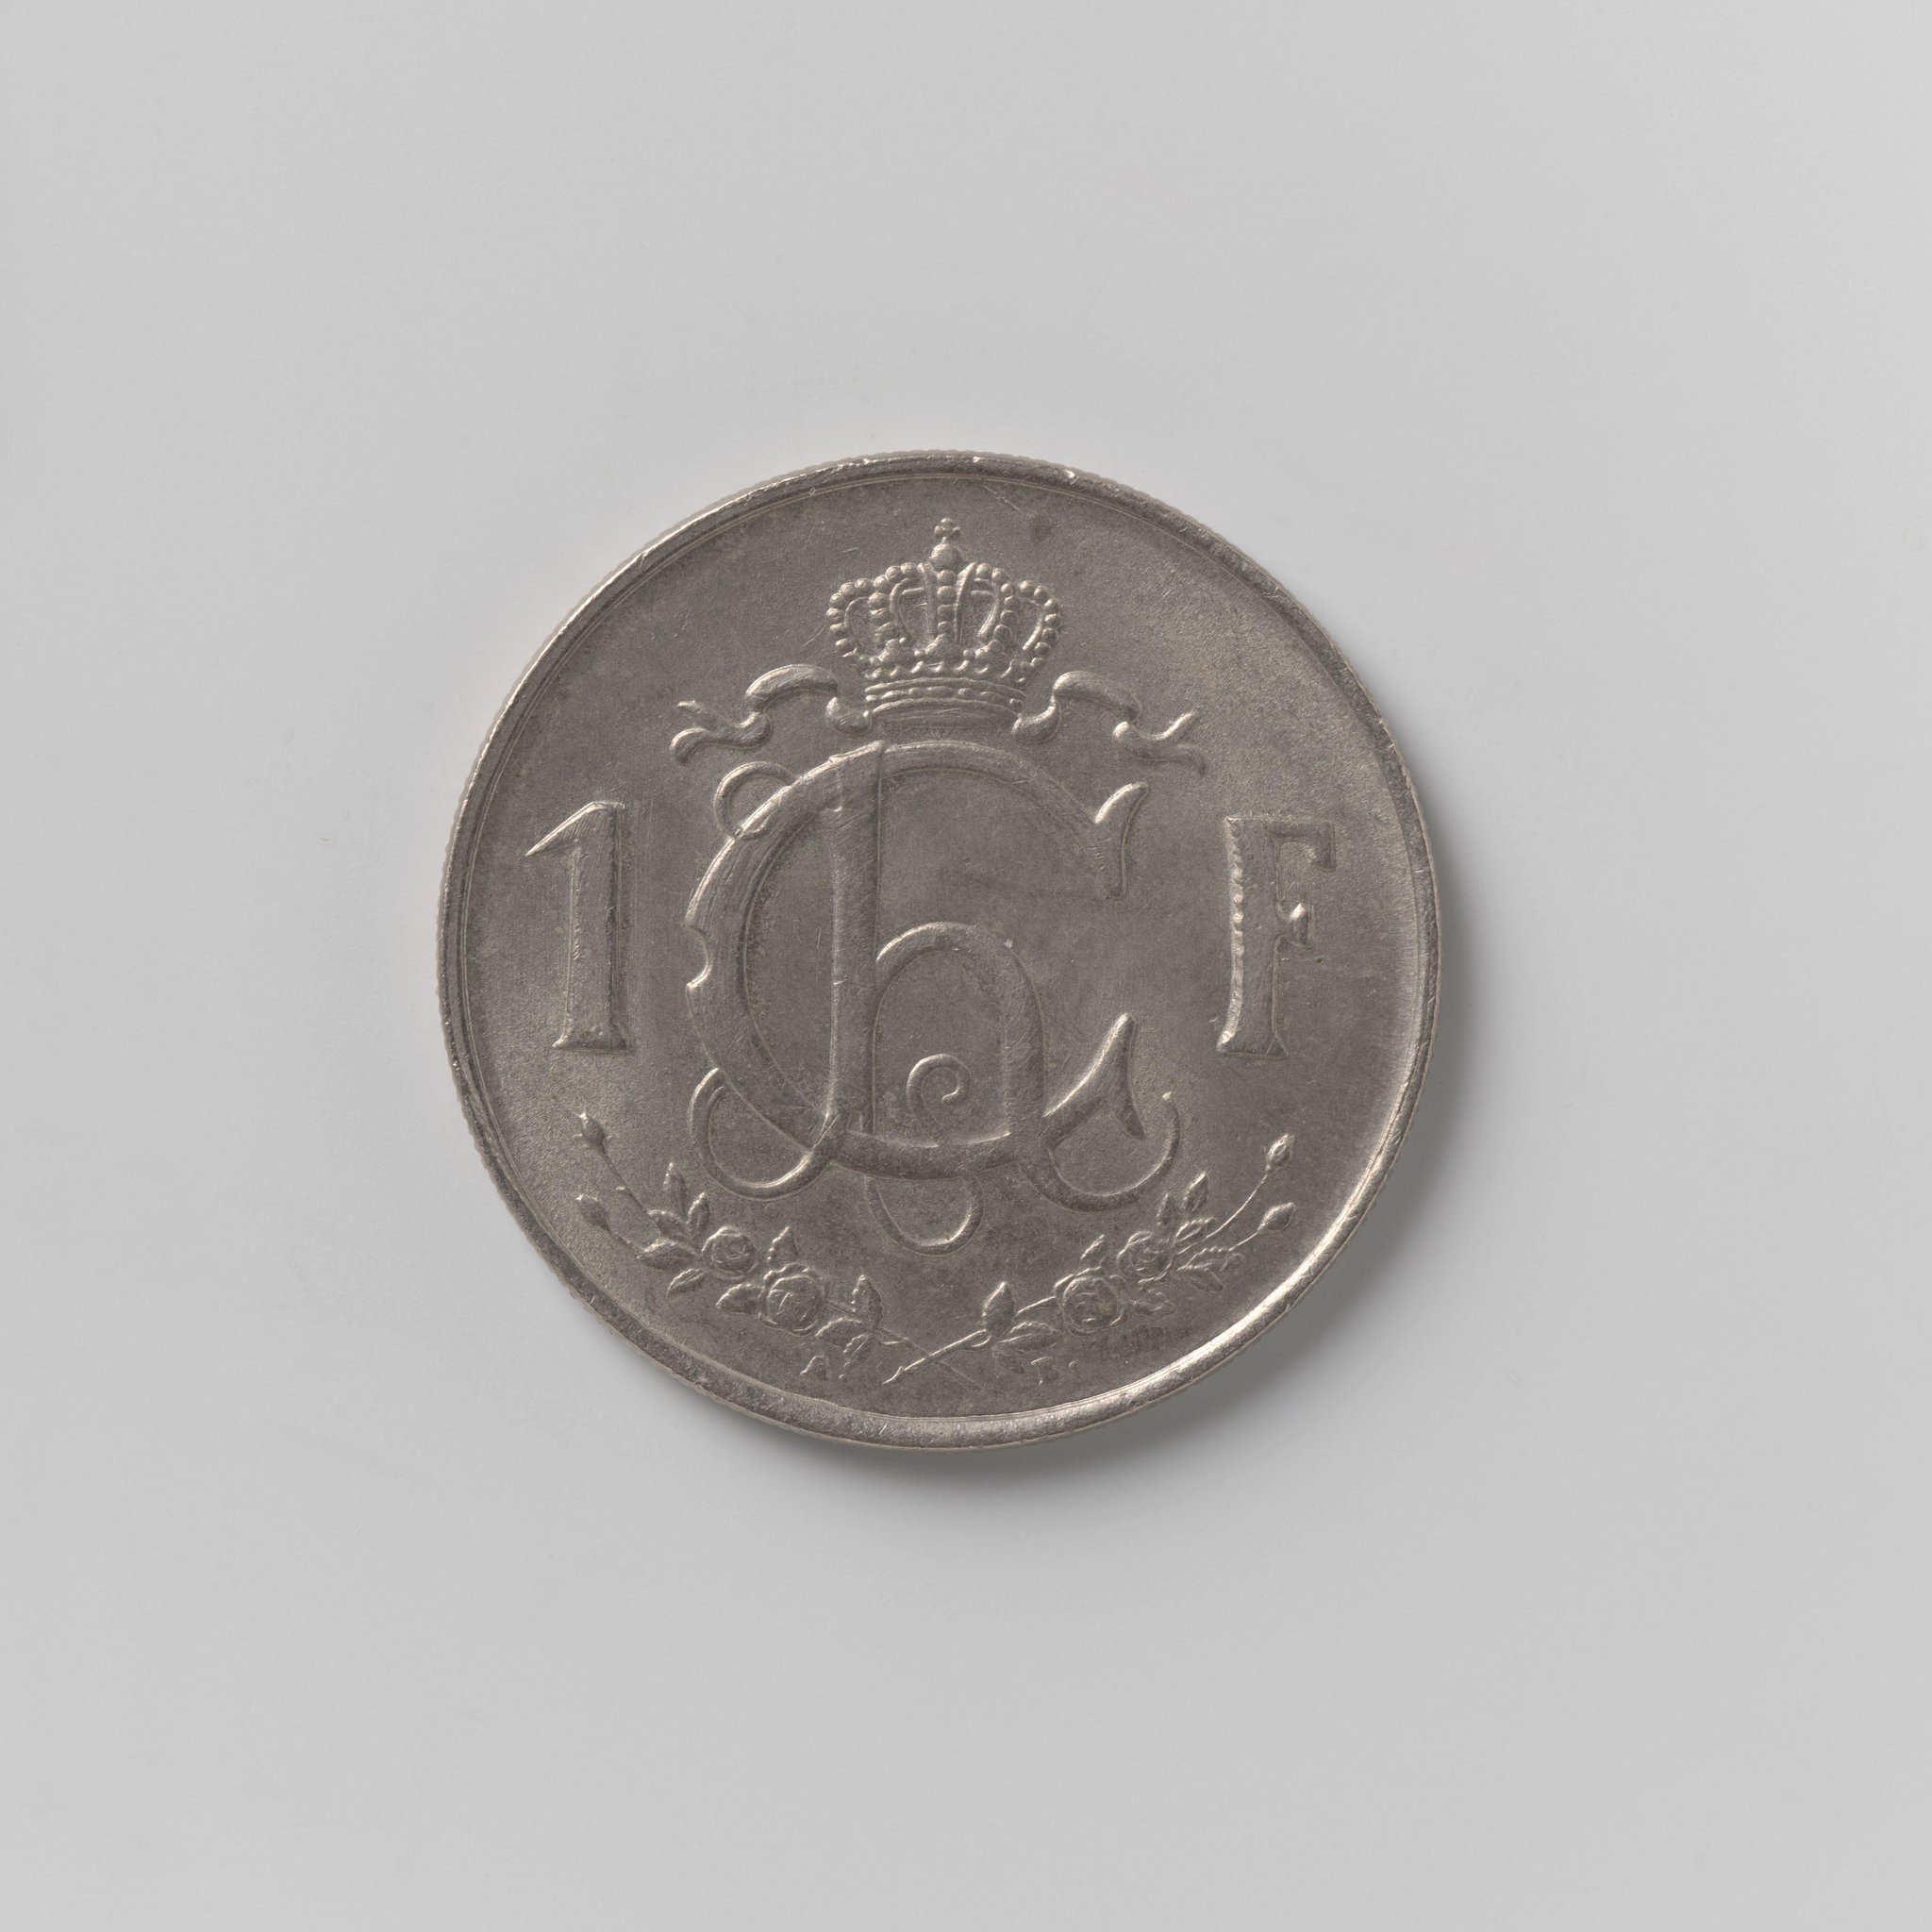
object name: coin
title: Frank uit Luxemburg van Charlotte, 1952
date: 1952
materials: nickel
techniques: striking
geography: brussels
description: Nikkelen munt. Voorzijde: tussen waarde-aanduiding gekroond monogram van de letters C en H. Keerzijde: tegen achtergrond van industriële activiteiten stoker met schep naar rechts. Jaartal in afsnede. Kartelrand.